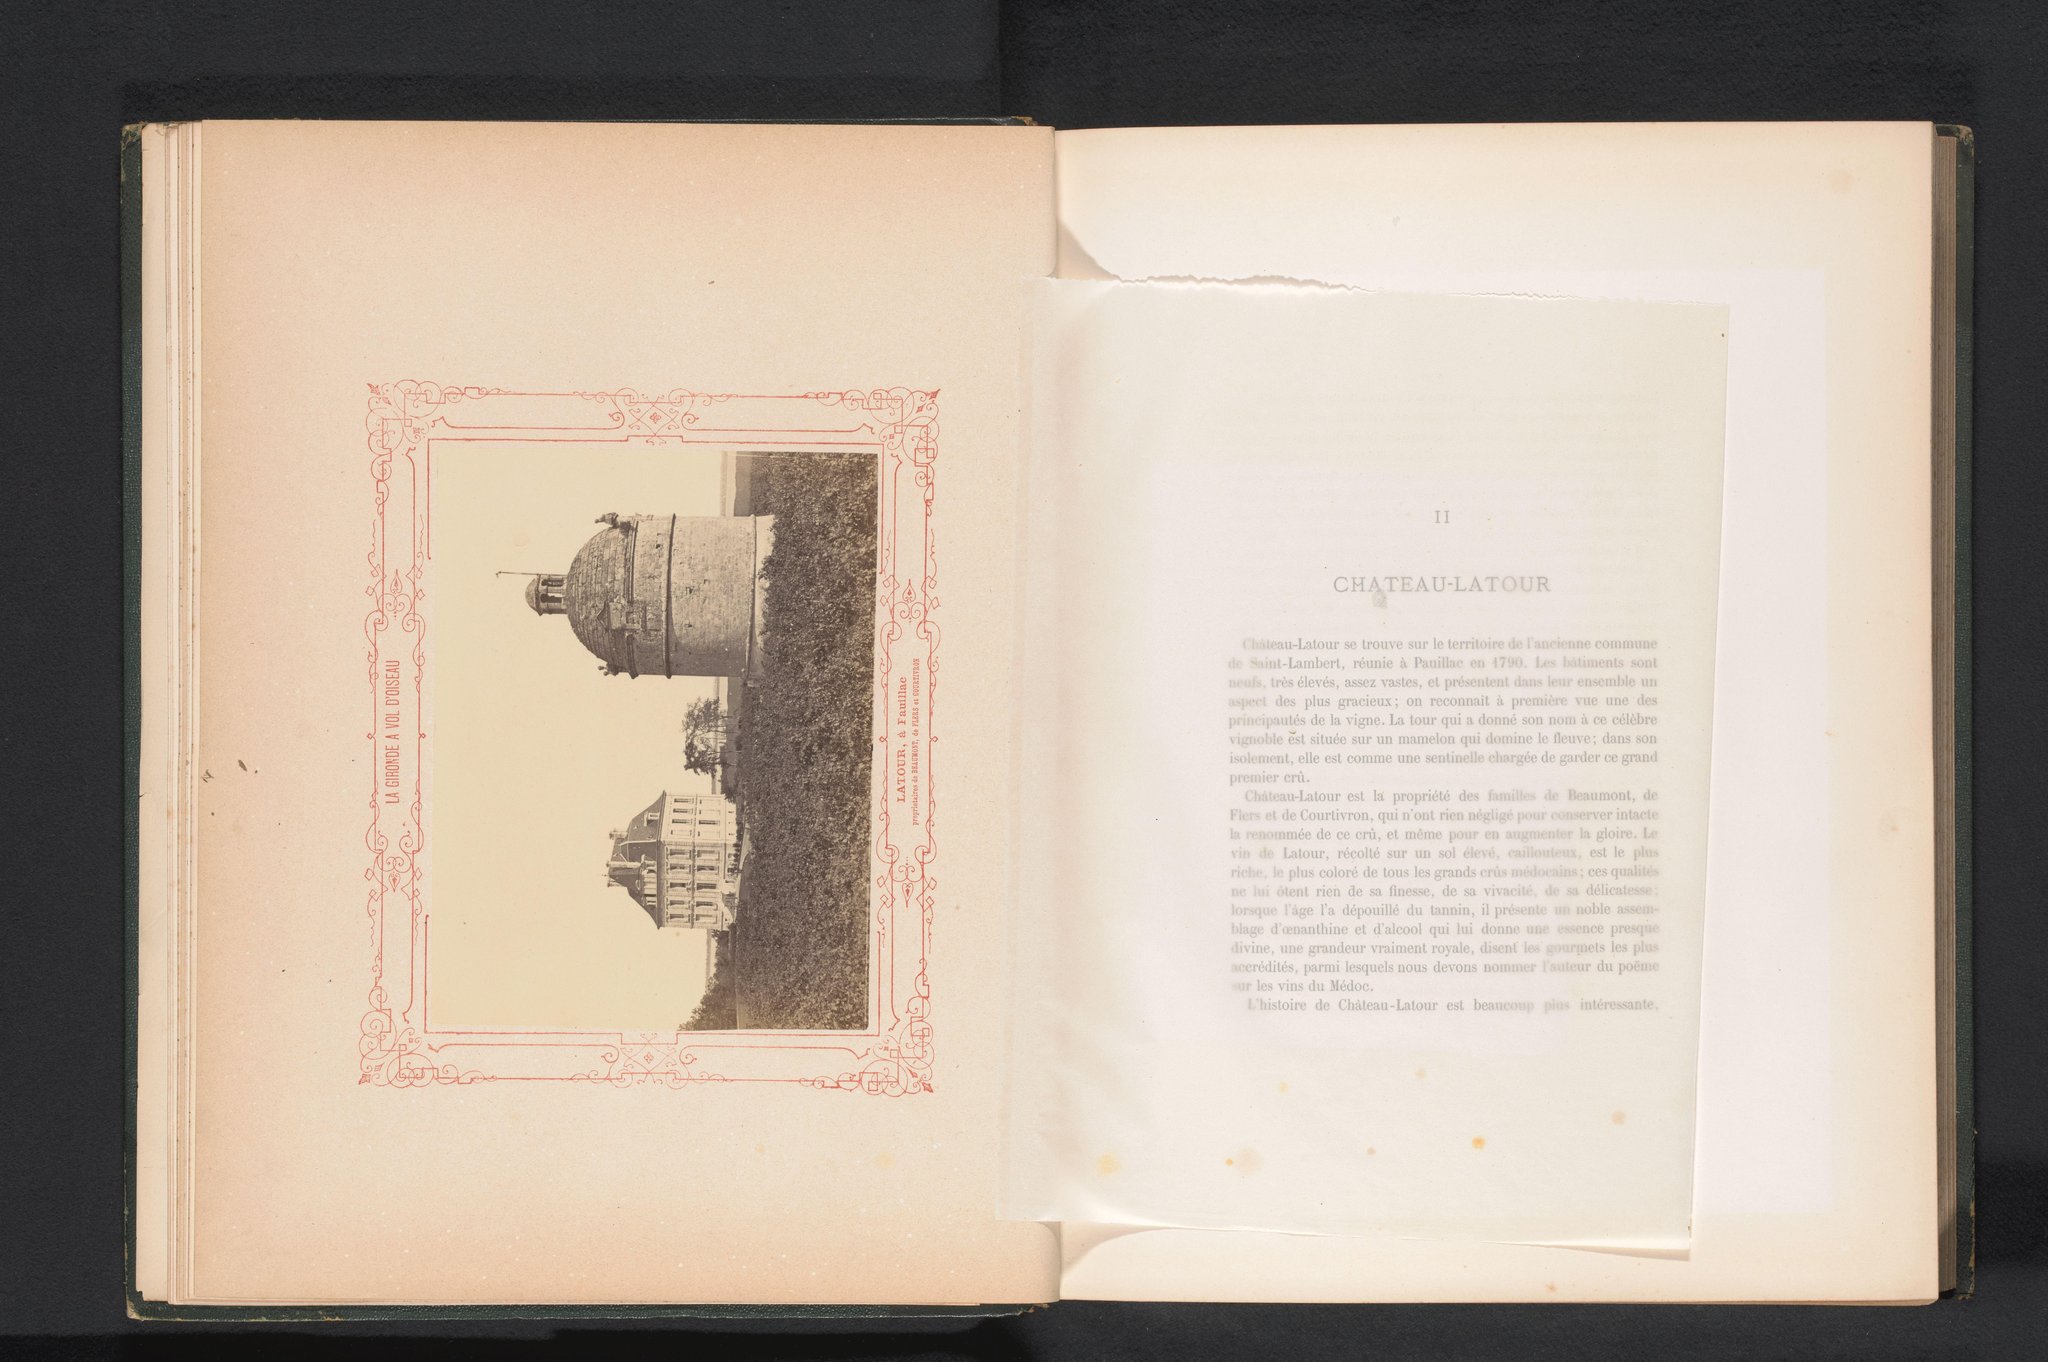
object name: photograph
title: Latour, à Pauillac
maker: alfred danflou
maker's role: fotograaf, schrijver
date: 1862-1867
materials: photographic support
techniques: albumen print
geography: pauillac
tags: castle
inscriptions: inscription: ‘proprietaires de BEAUMONT, de FLERS et COUTIVRON’